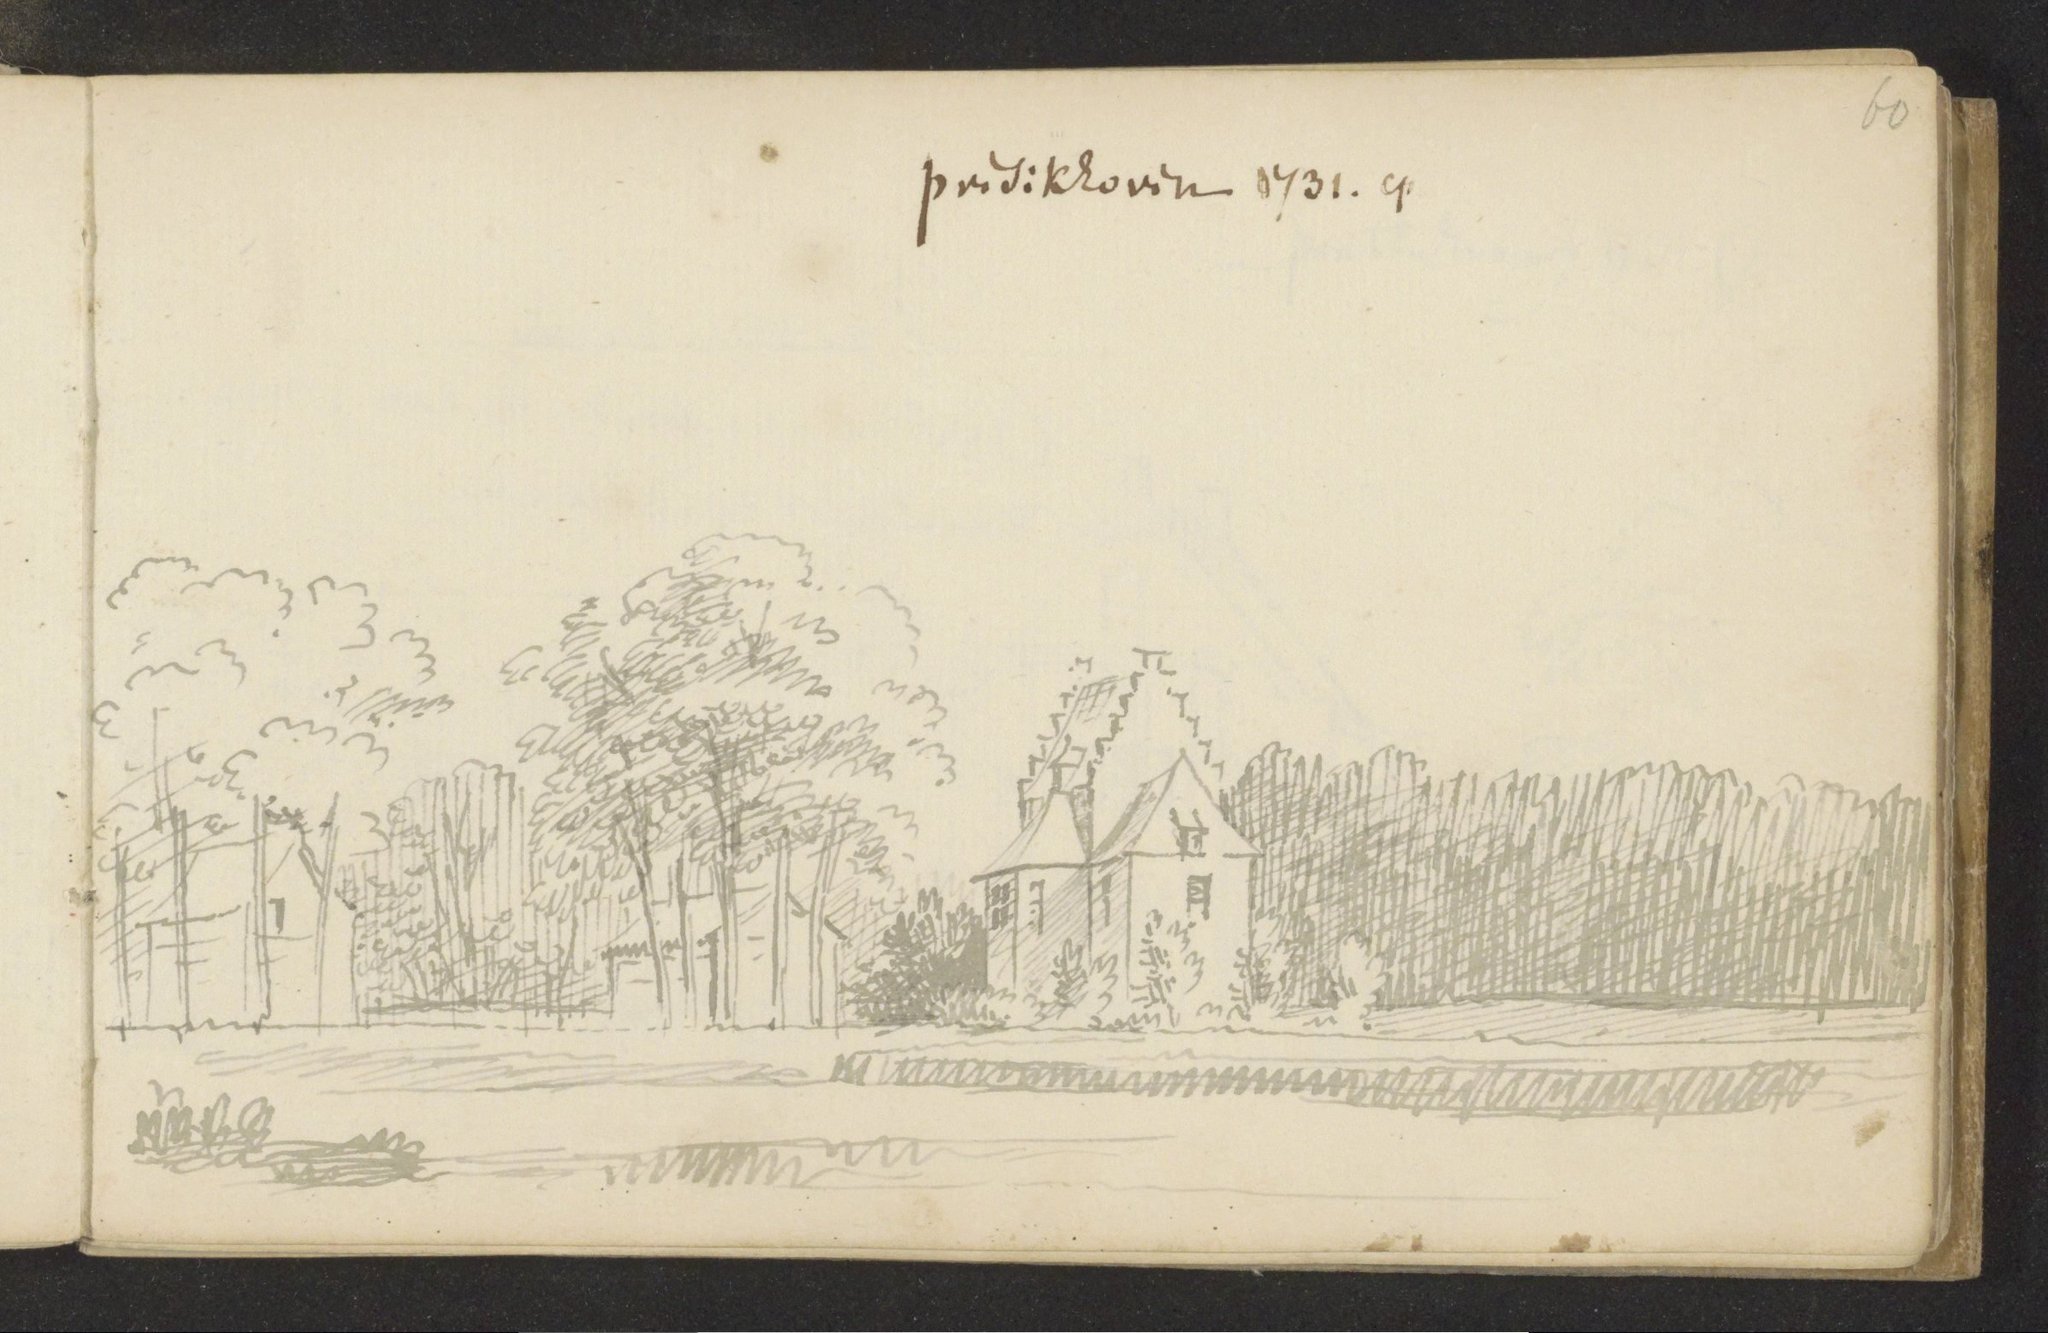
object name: sketchbook leaf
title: Huis Presikhaaf bij Arnhem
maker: abraham de haen (ii)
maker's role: draughtsman, print maker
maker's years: 1707-1748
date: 1731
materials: ink, paper, pencil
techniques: pen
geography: arnhem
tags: country-house, arnhem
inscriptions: date and inscription: ‘Presikhoven 1731.cp’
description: Blad 60 recto uit een schetsboek met 78 bladen.